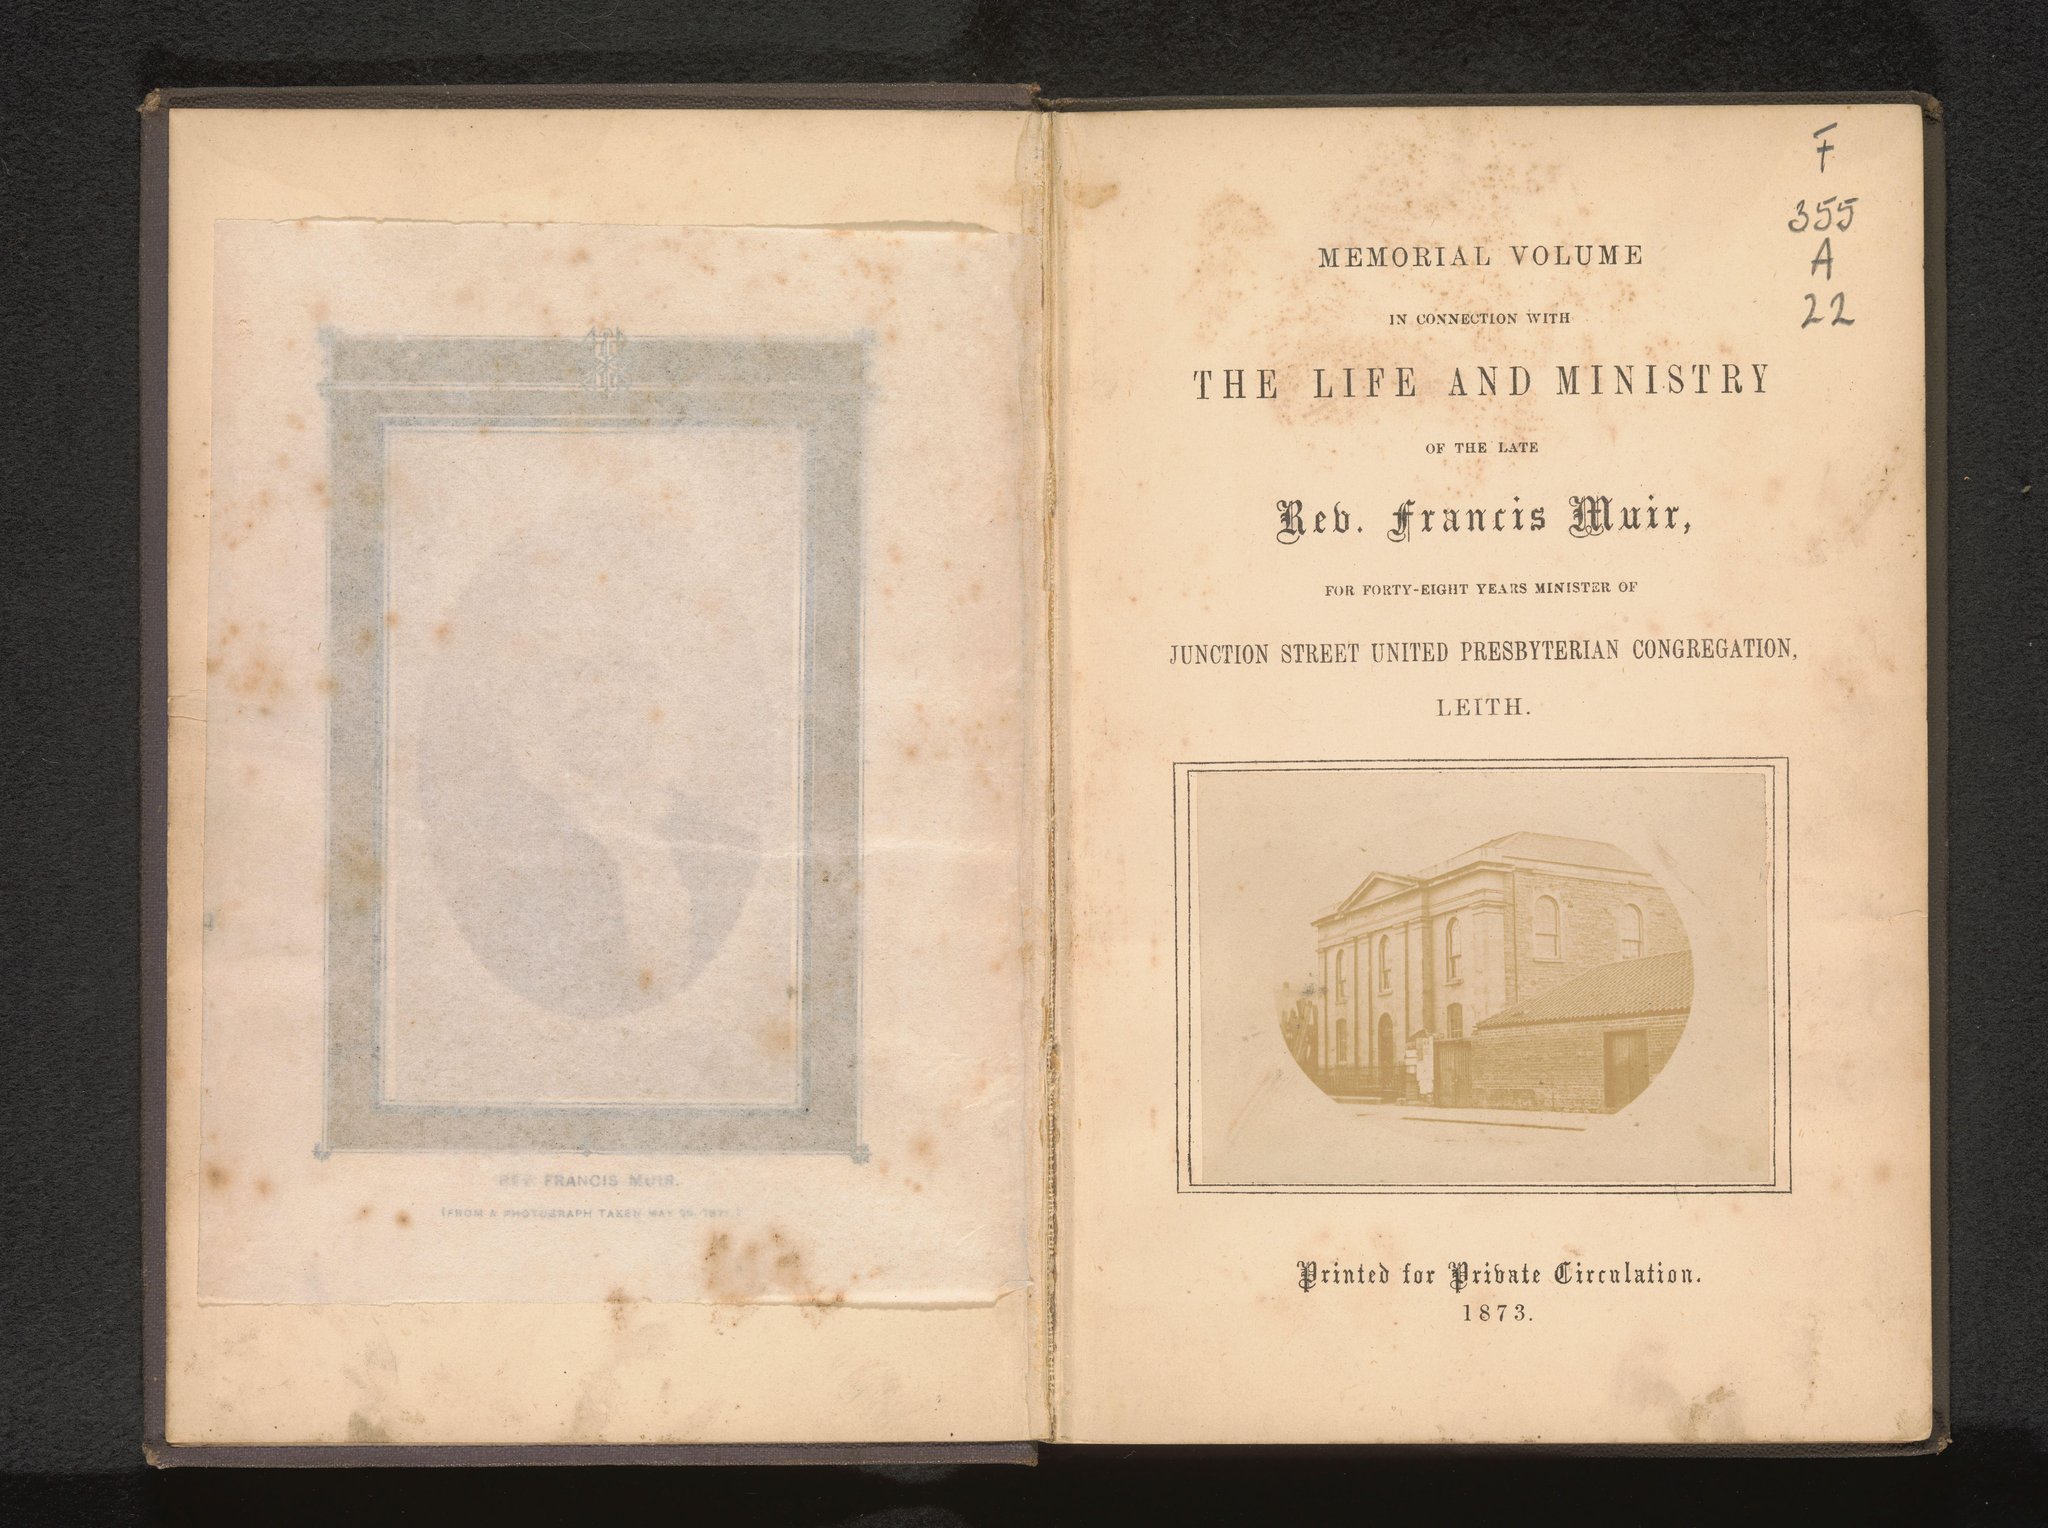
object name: book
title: Memorial volume in connection with the life and ministry of the late Rev. Francis Muir, for forty-eight years Minister of Junction Street United Presbyterian Congregation, Leith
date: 1873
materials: cardboard, linen, paper, photographic support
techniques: albumen print, printing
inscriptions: name: ‘Mr Richard H Scott No 14 Boatfield Lane Leit April 27th 1875’